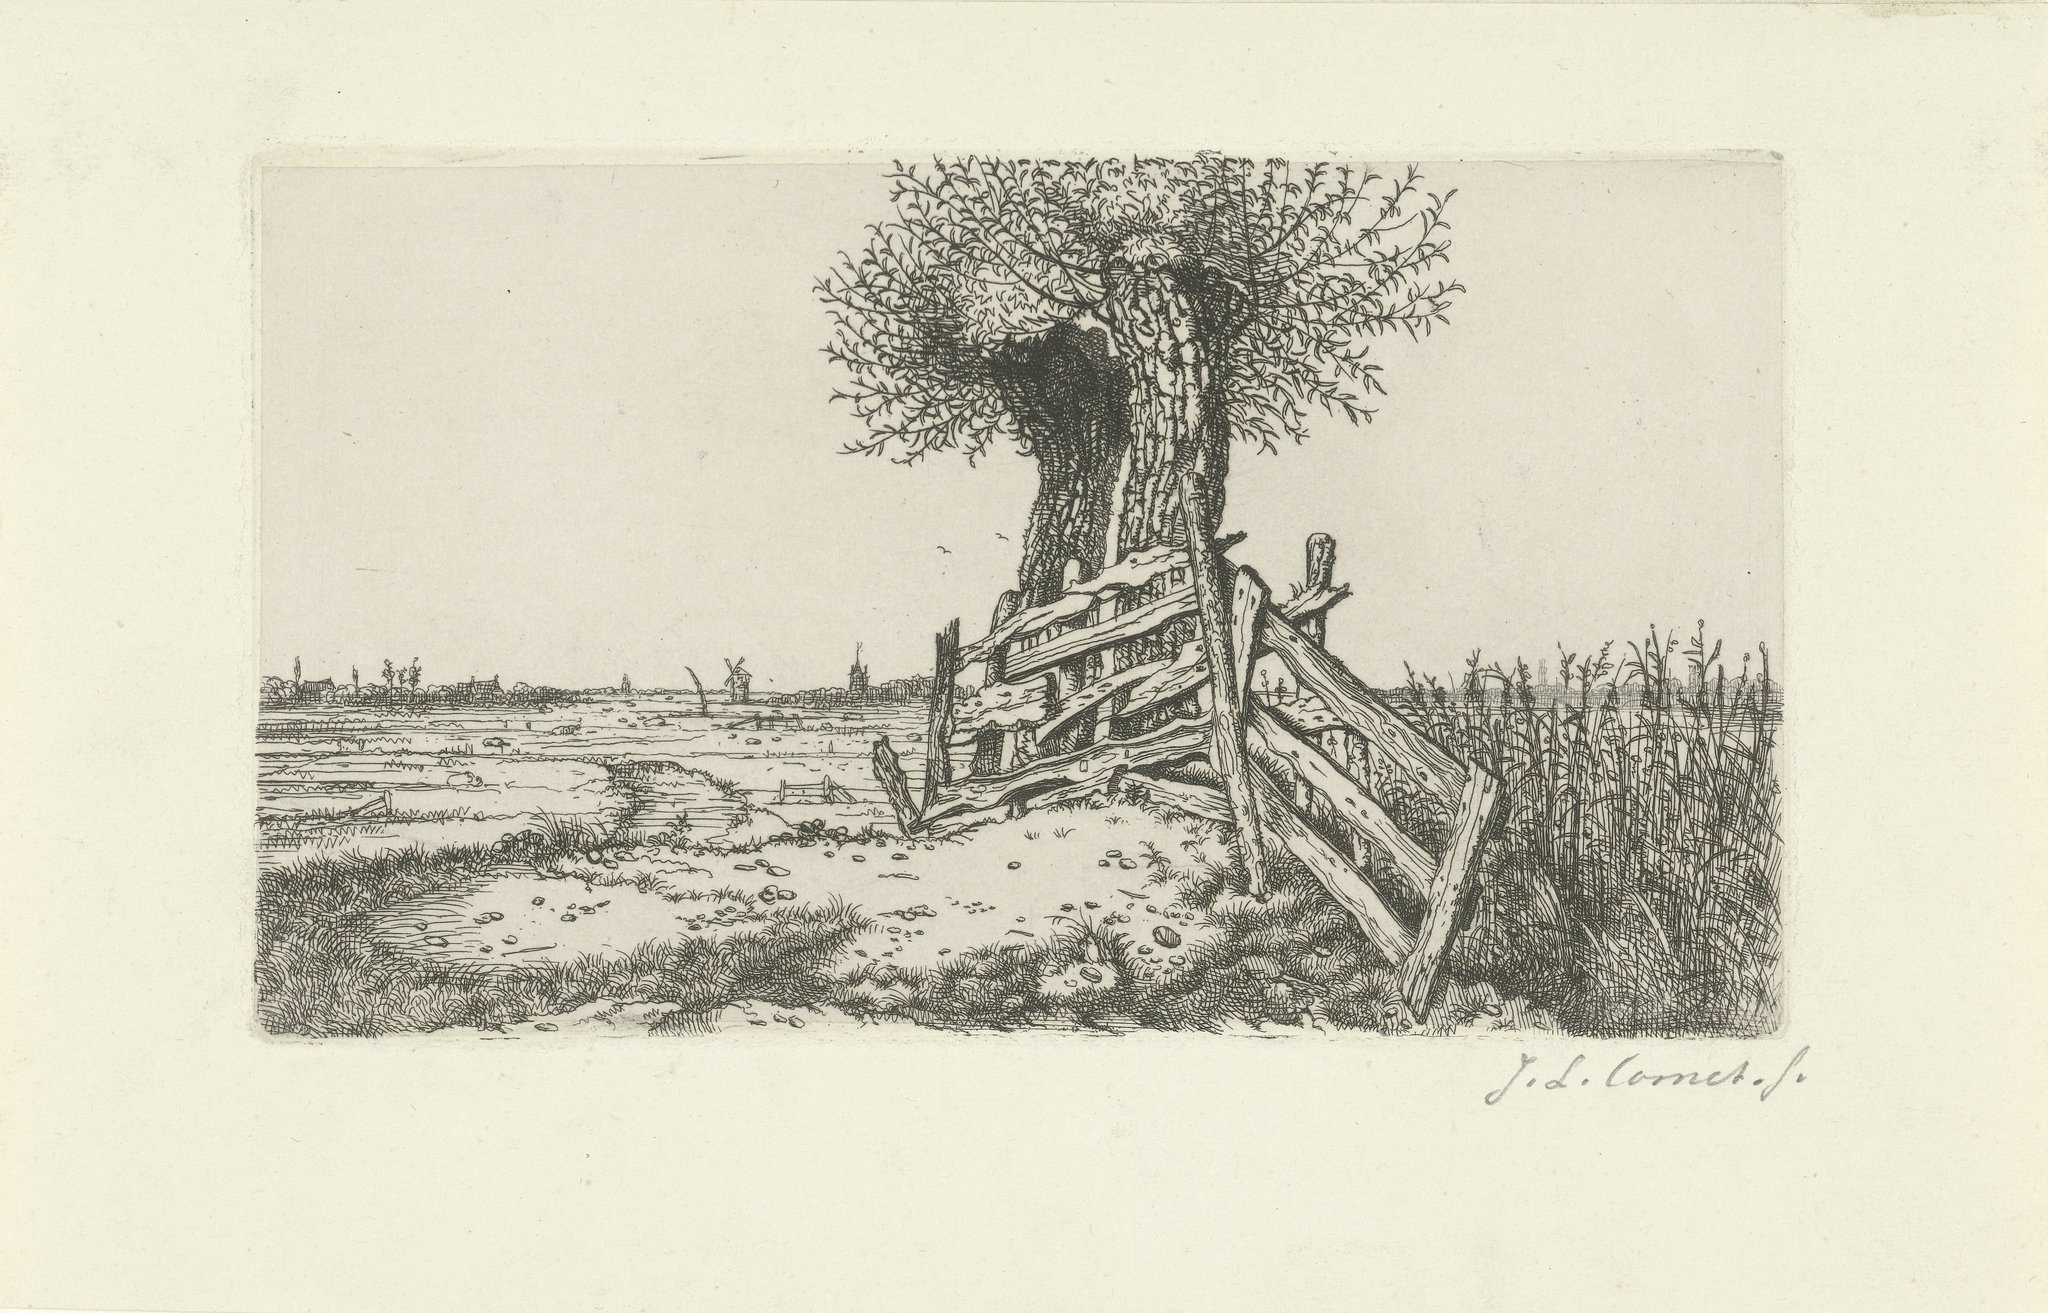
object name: print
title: Polderlandschap met hekje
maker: jacobus ludovicus cornet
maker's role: draughtsman, print maker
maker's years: 1815-1882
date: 1825-1882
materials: paper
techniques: etching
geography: leiden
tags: fence, wall, paling, trees: willow, polder, reclaimed land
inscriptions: collector's mark: Lugt 2228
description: Polderlandschap met hekje. Achter het hekje enkele knotwilgen